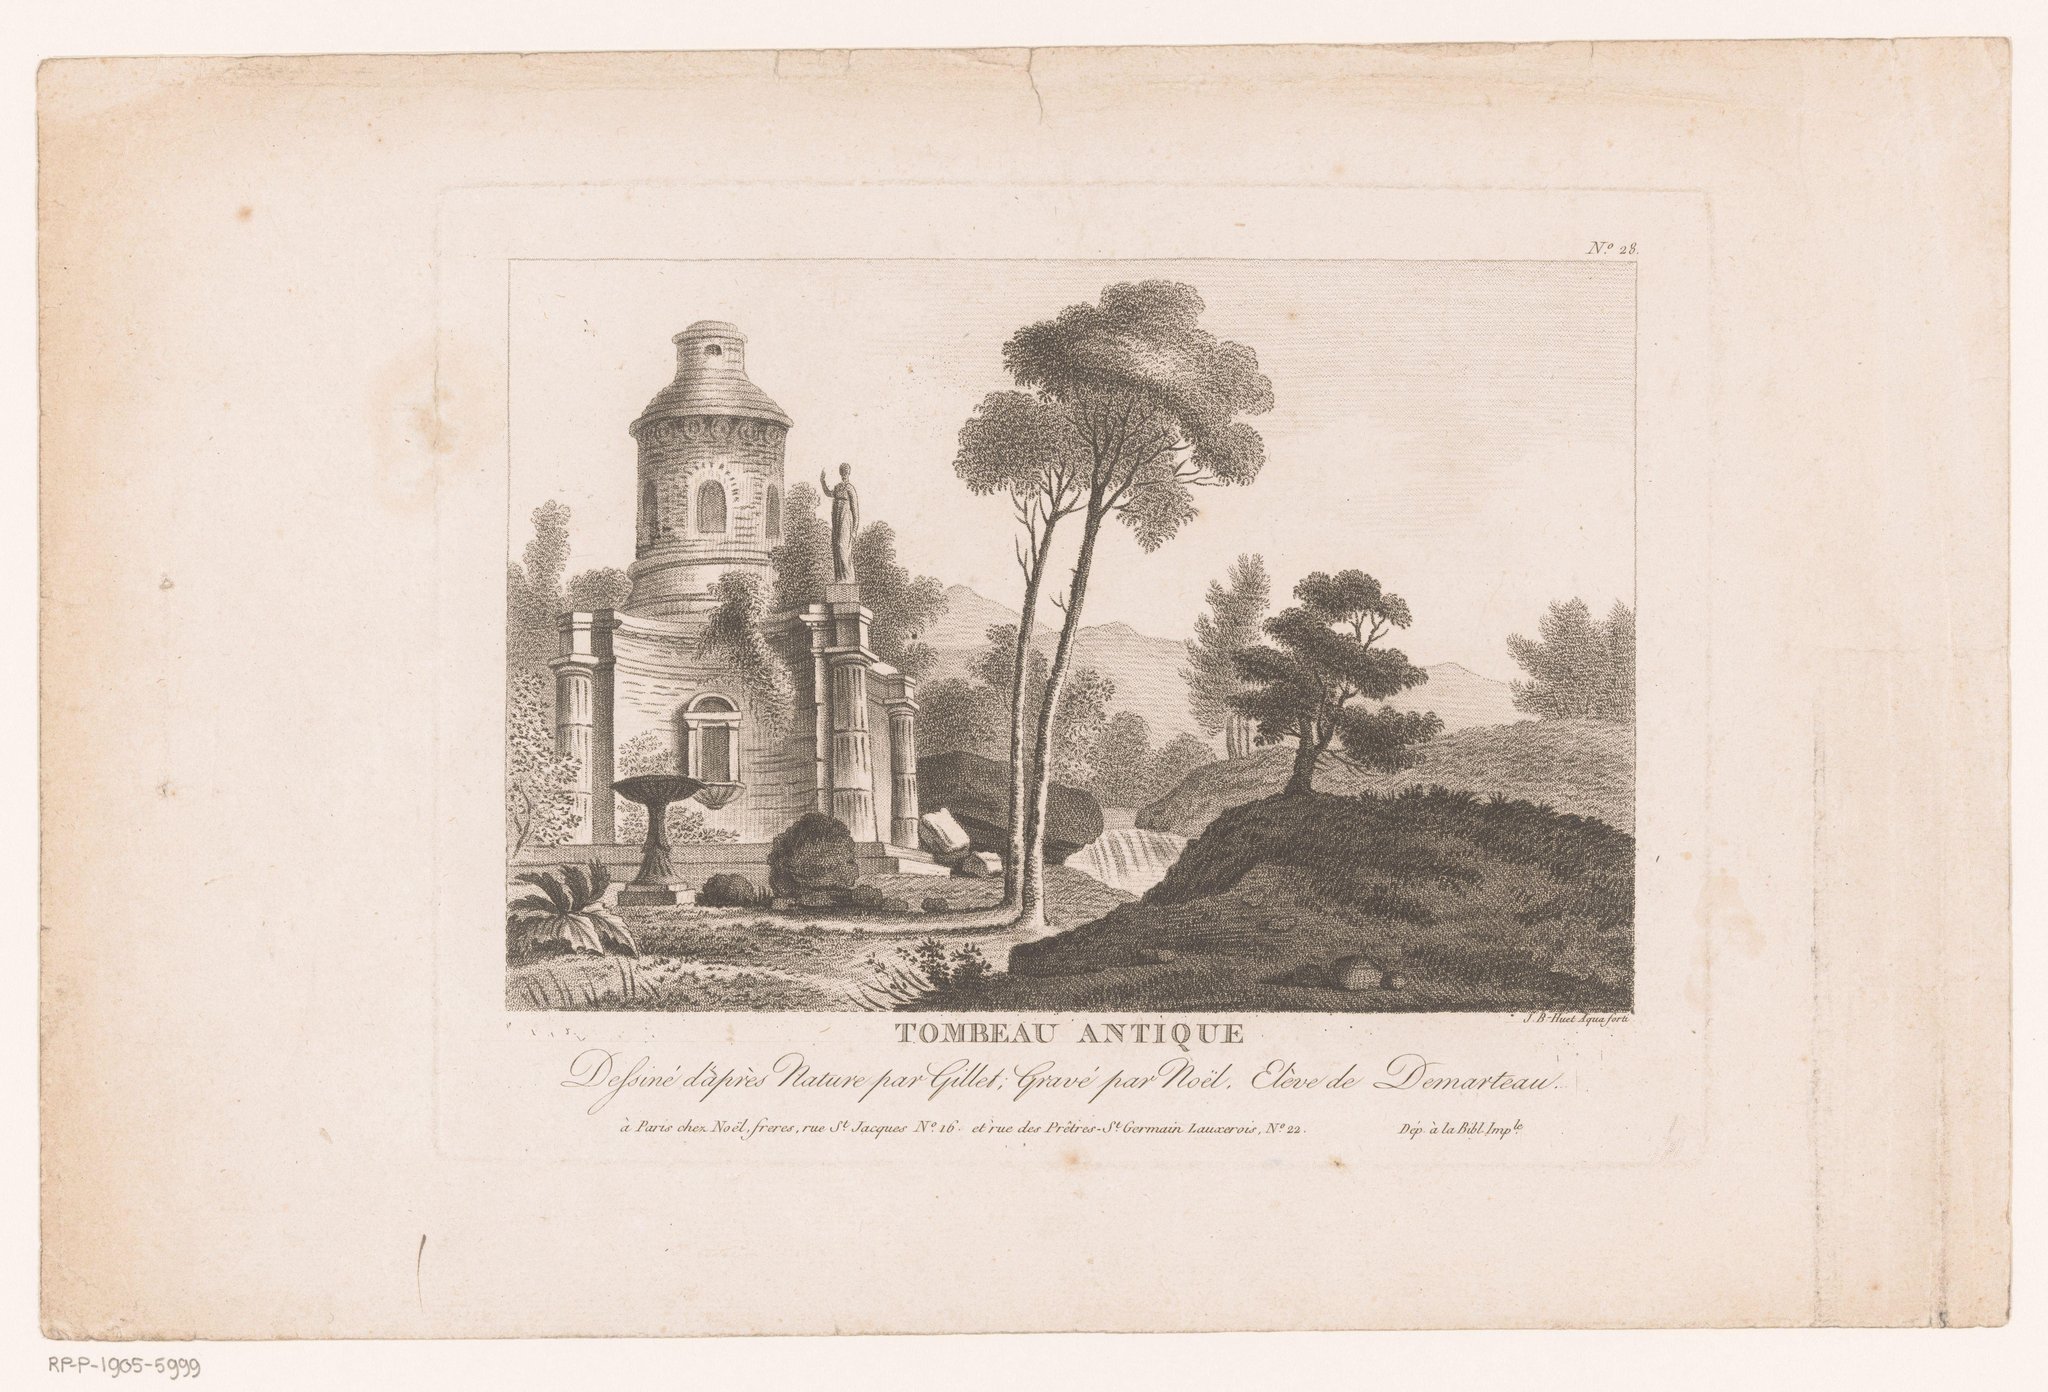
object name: print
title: Tombeau Antique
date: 1755-1811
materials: paper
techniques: etching, roulette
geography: paris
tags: landscape with ruins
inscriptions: : ‘Dép. à la Bibl. Imple.’, collector's mark: Lugt 2228